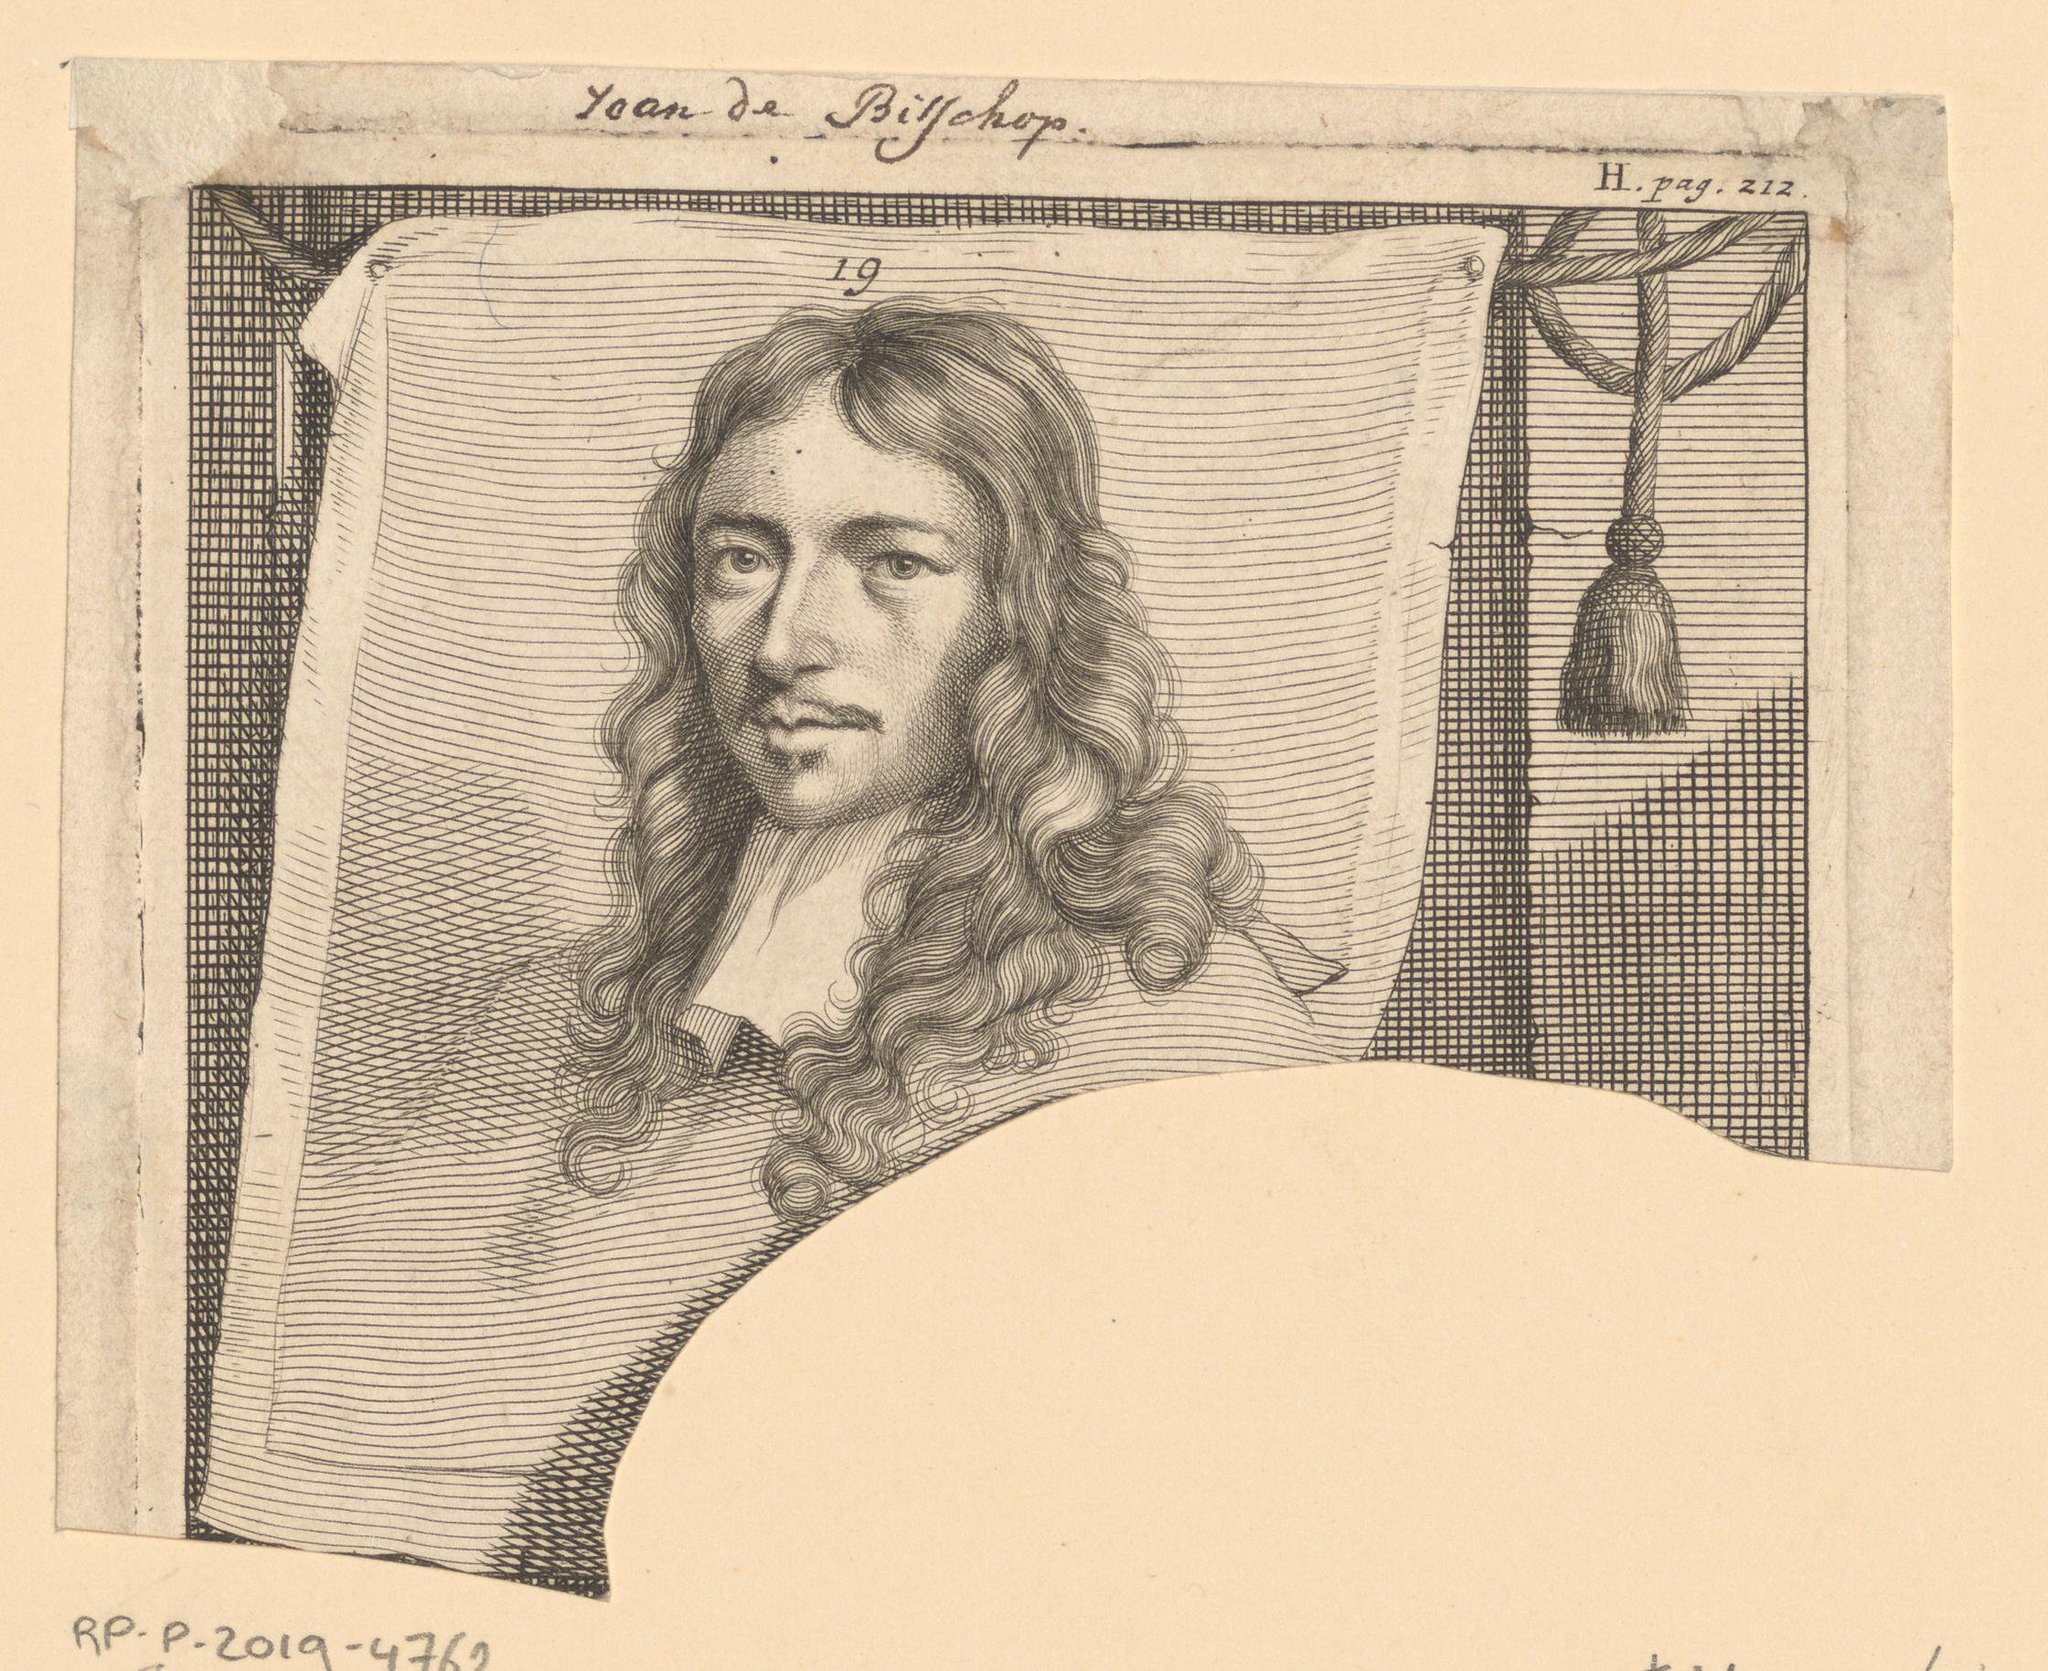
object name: print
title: Portret van Jan de Bisschop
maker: jacob houbraken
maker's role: draughtsman, print maker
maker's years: 1698-1780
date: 1621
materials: paper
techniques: engraving, etching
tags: jan de bisschop, historical persons, portrait, self-portrait of painter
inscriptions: inscription: ‘Joan de Bisschop [...]’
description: Prent uit: Houbraken, Arnold. De groote schouburgh der Nederlantsche konstschilders en schilderessen. Amsterdam: s.n., 1721, dl. 2.